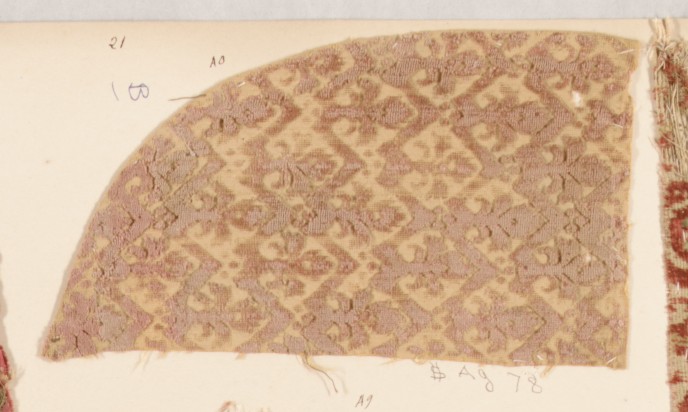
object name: fragment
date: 1501-1600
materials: silk